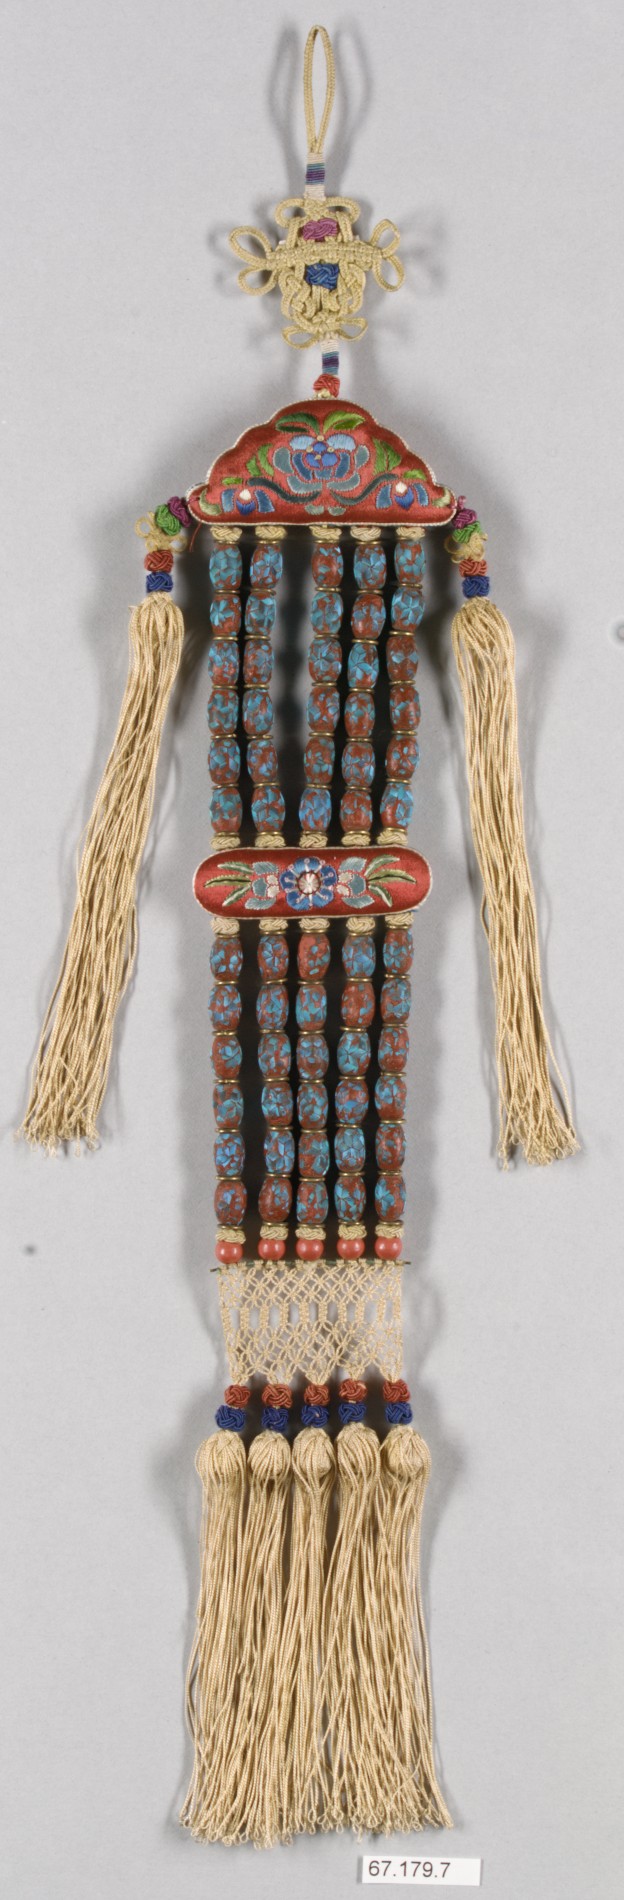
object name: hanging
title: Small Hanging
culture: chinese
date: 1644-1911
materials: brass, feather, silk